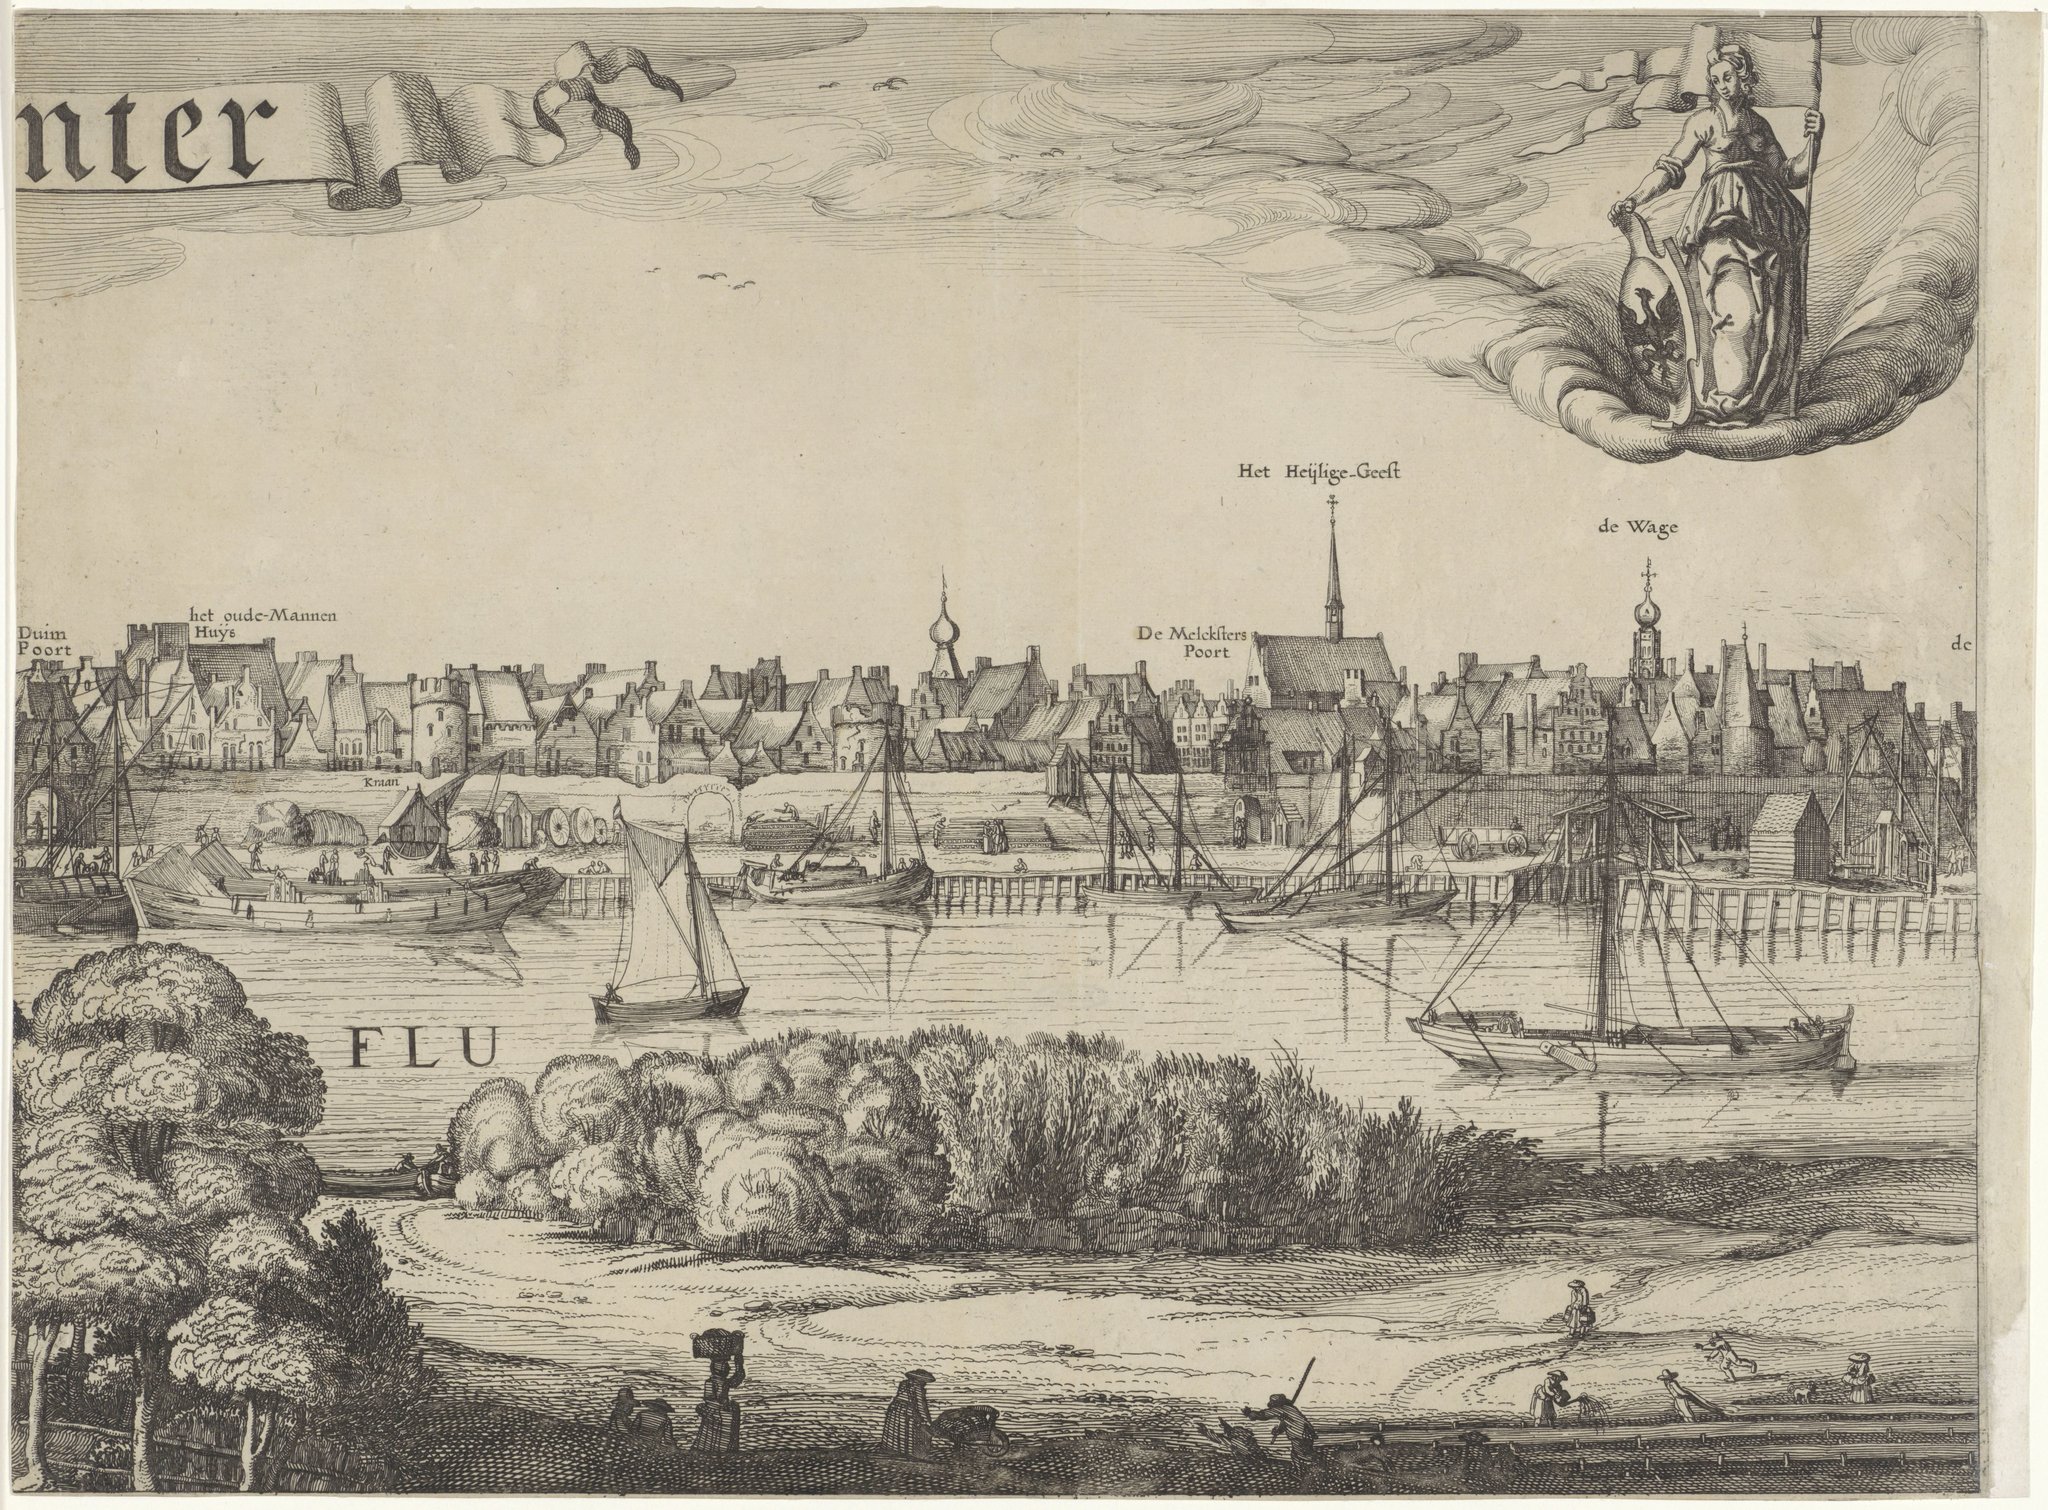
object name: print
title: Profiel van Deventer (plaat III)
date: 1615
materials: paper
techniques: etching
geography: amsterdam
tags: landscapes, church (exterior), prospect of city, town panorama, silhouette of city, deventer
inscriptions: collector's mark: Lugt 2228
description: Plaat rechtsmidden van 'Profiel van Deventer', met een gezicht op een gedeelte van de stad Deventer. Op de voorgrond werken boeren op de akkers en daarachter stroomt de rivier de IJssel. Op de rivier varen diverse boten. Achter de stadsmuren zijn enkele belangrijke gebouwen te herkennen, waaronder de waag. Linksboven een banderol met een deel van de titel van de prent en rechtsboven in de wolken een vrouw met een vlag en een wapenschild met het wapen van Deventer.